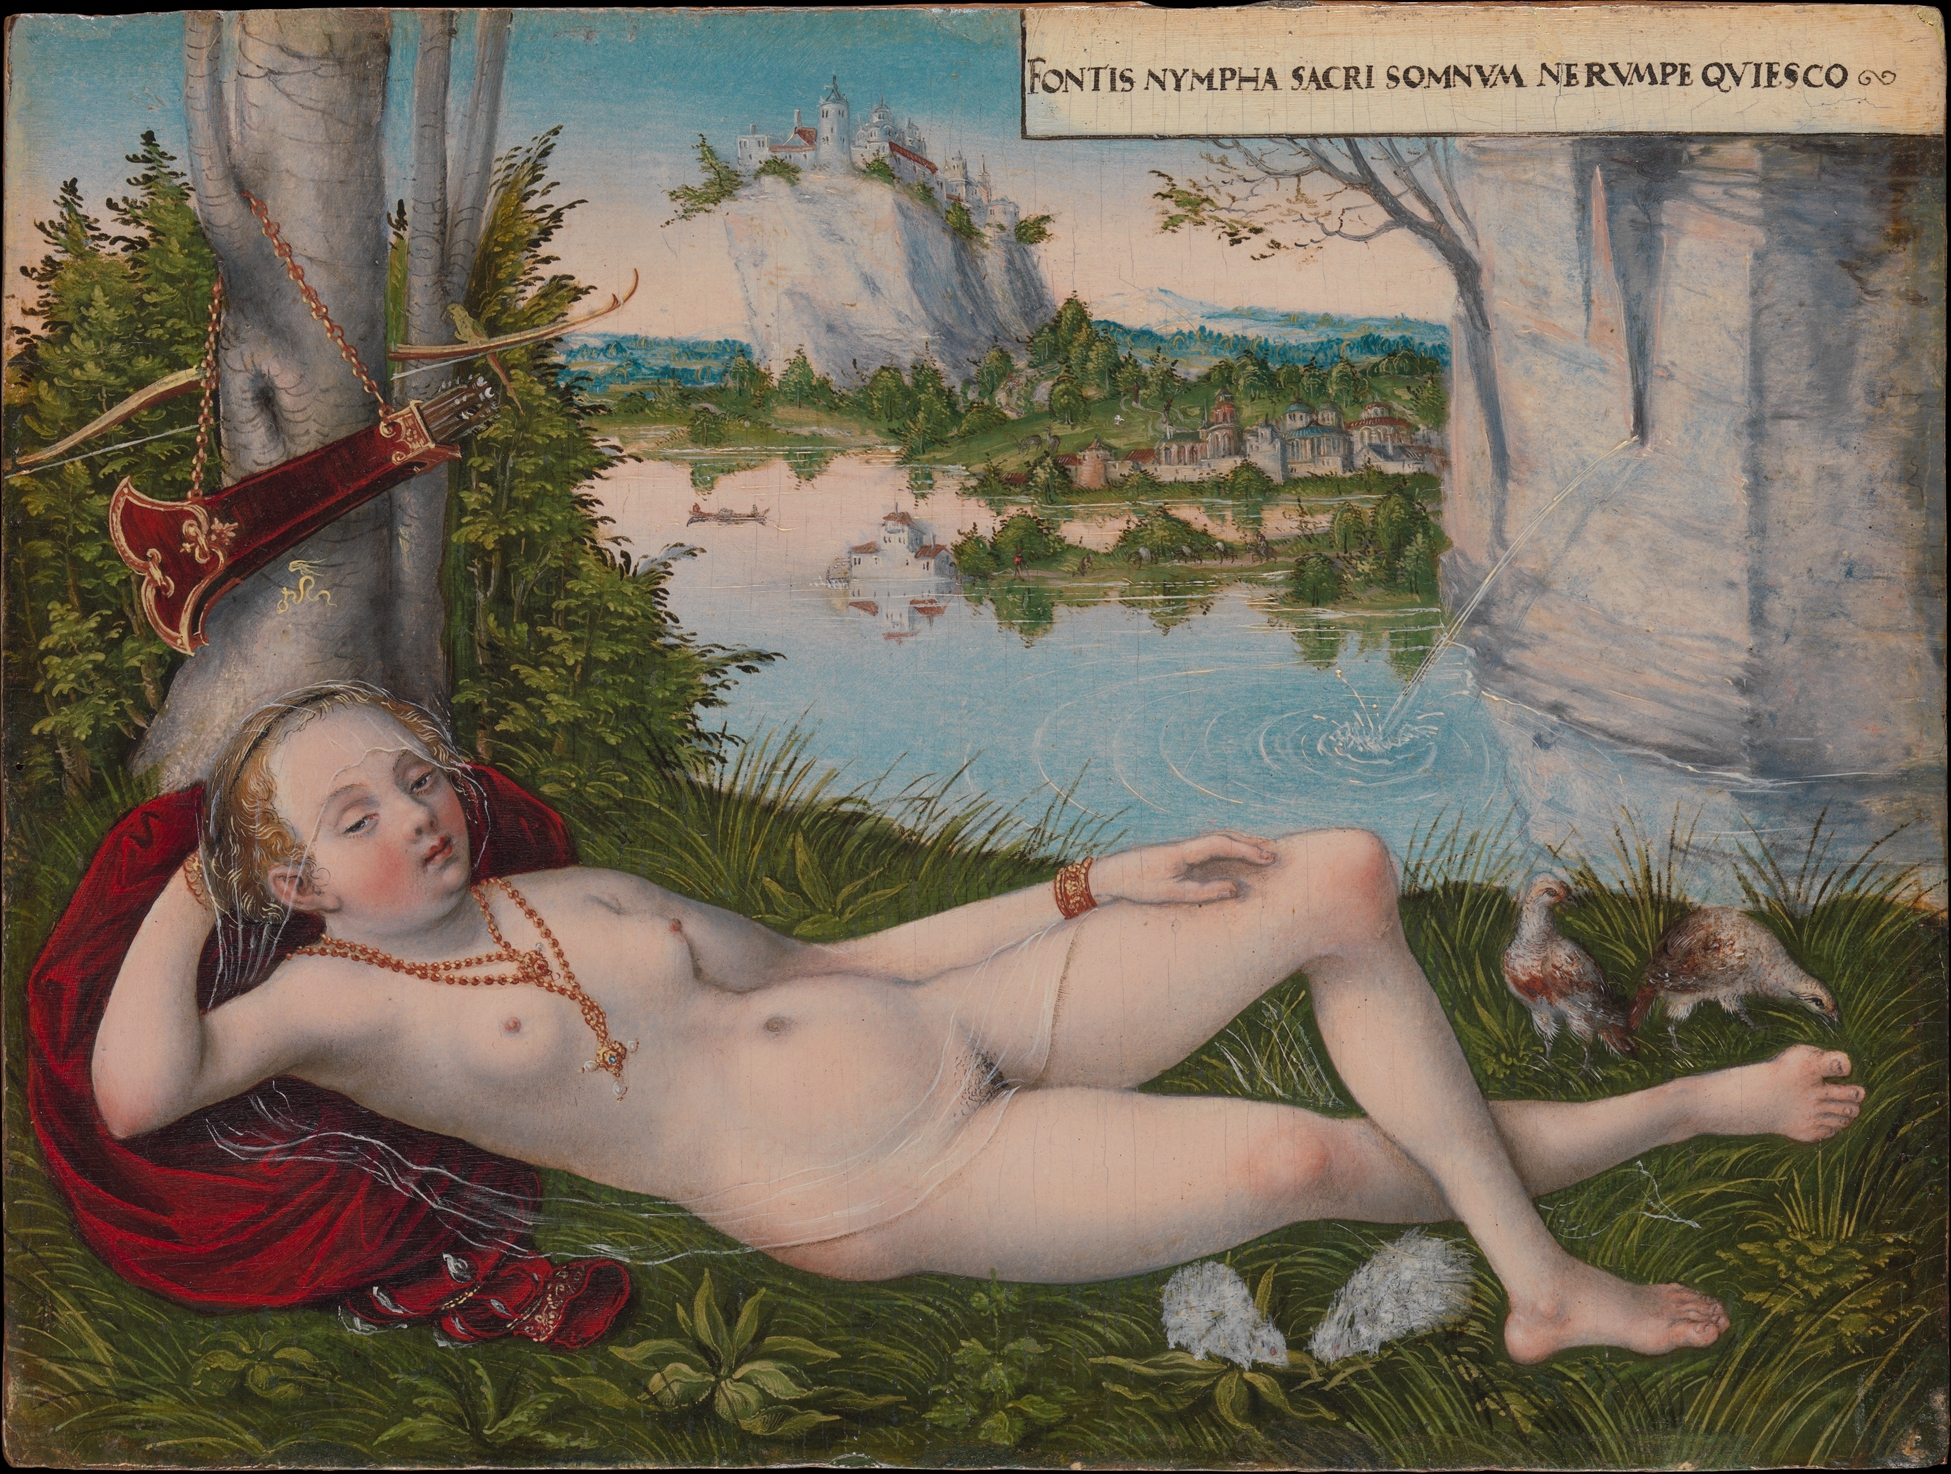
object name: painting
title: Nymph of the Spring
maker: lucas cranach the younger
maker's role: artist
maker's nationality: german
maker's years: 1515-1586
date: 1545-1550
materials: wood, oil, panel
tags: birds,female nudes,nymphs